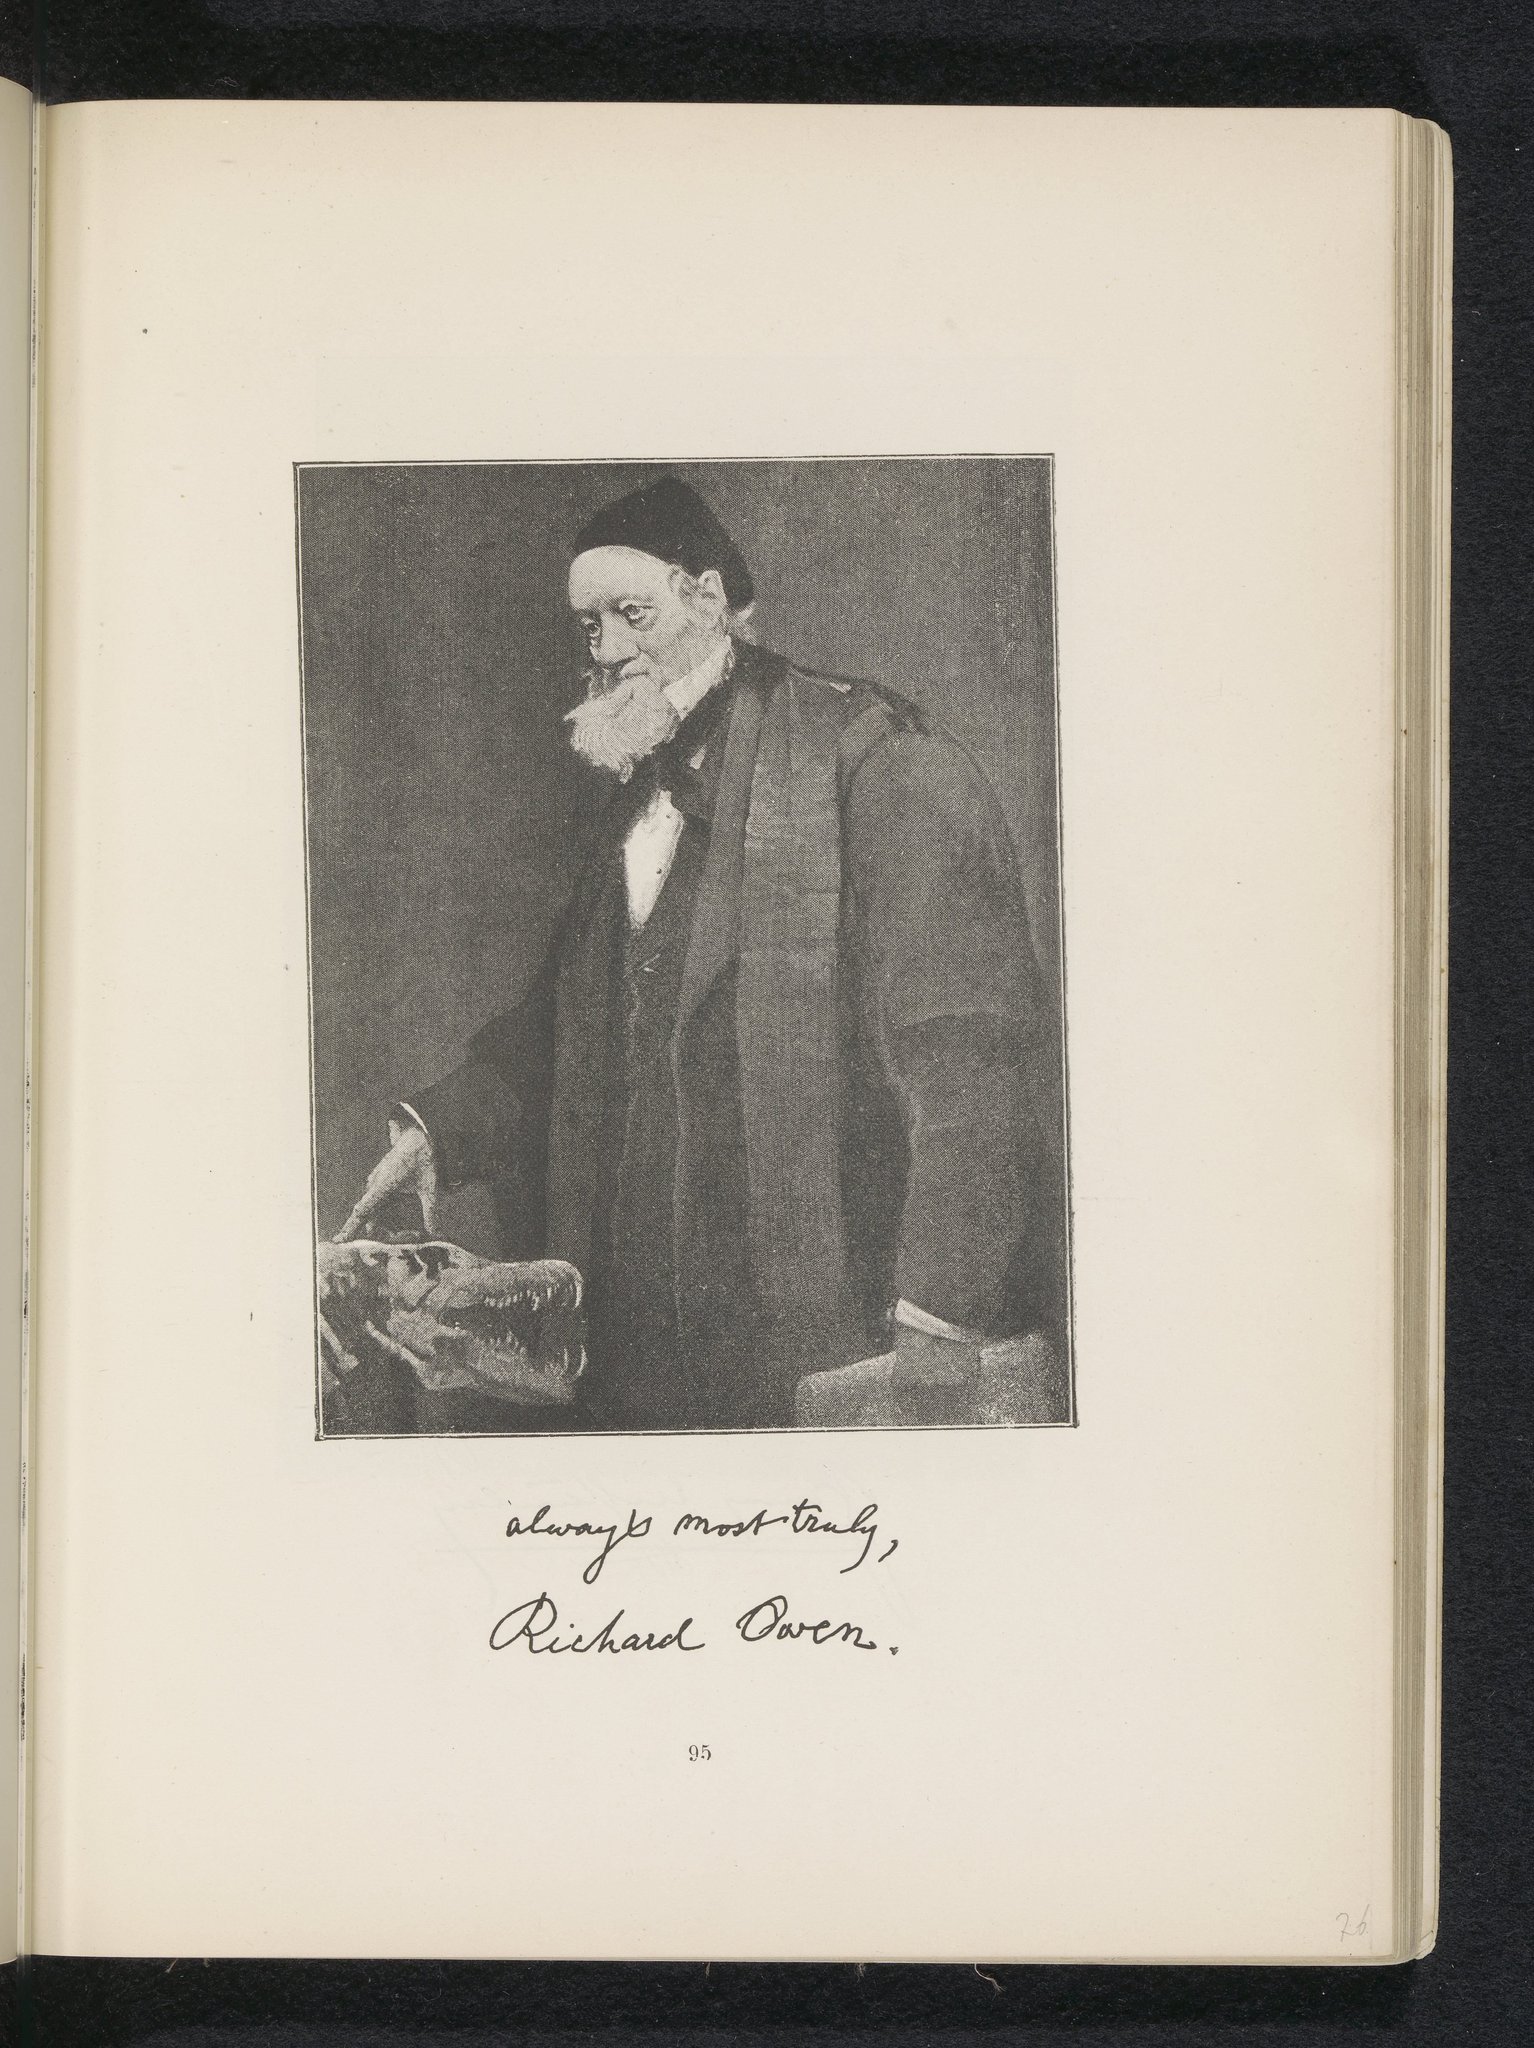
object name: page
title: Fotoreproductie van een schilderij, voorstellende een portret van Richard Owen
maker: Anonymous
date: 1881-1891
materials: paper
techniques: autotype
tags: zoology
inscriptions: inscription